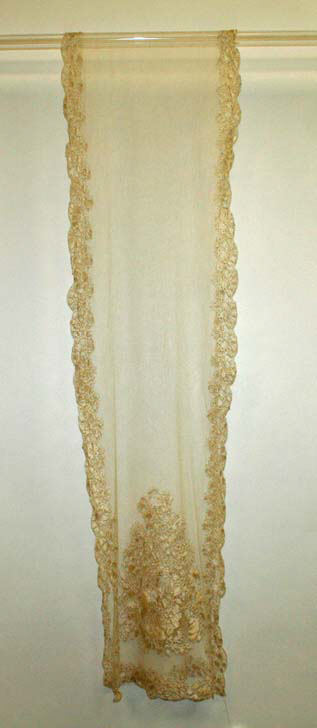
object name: stole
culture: spanish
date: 1820-1835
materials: silk